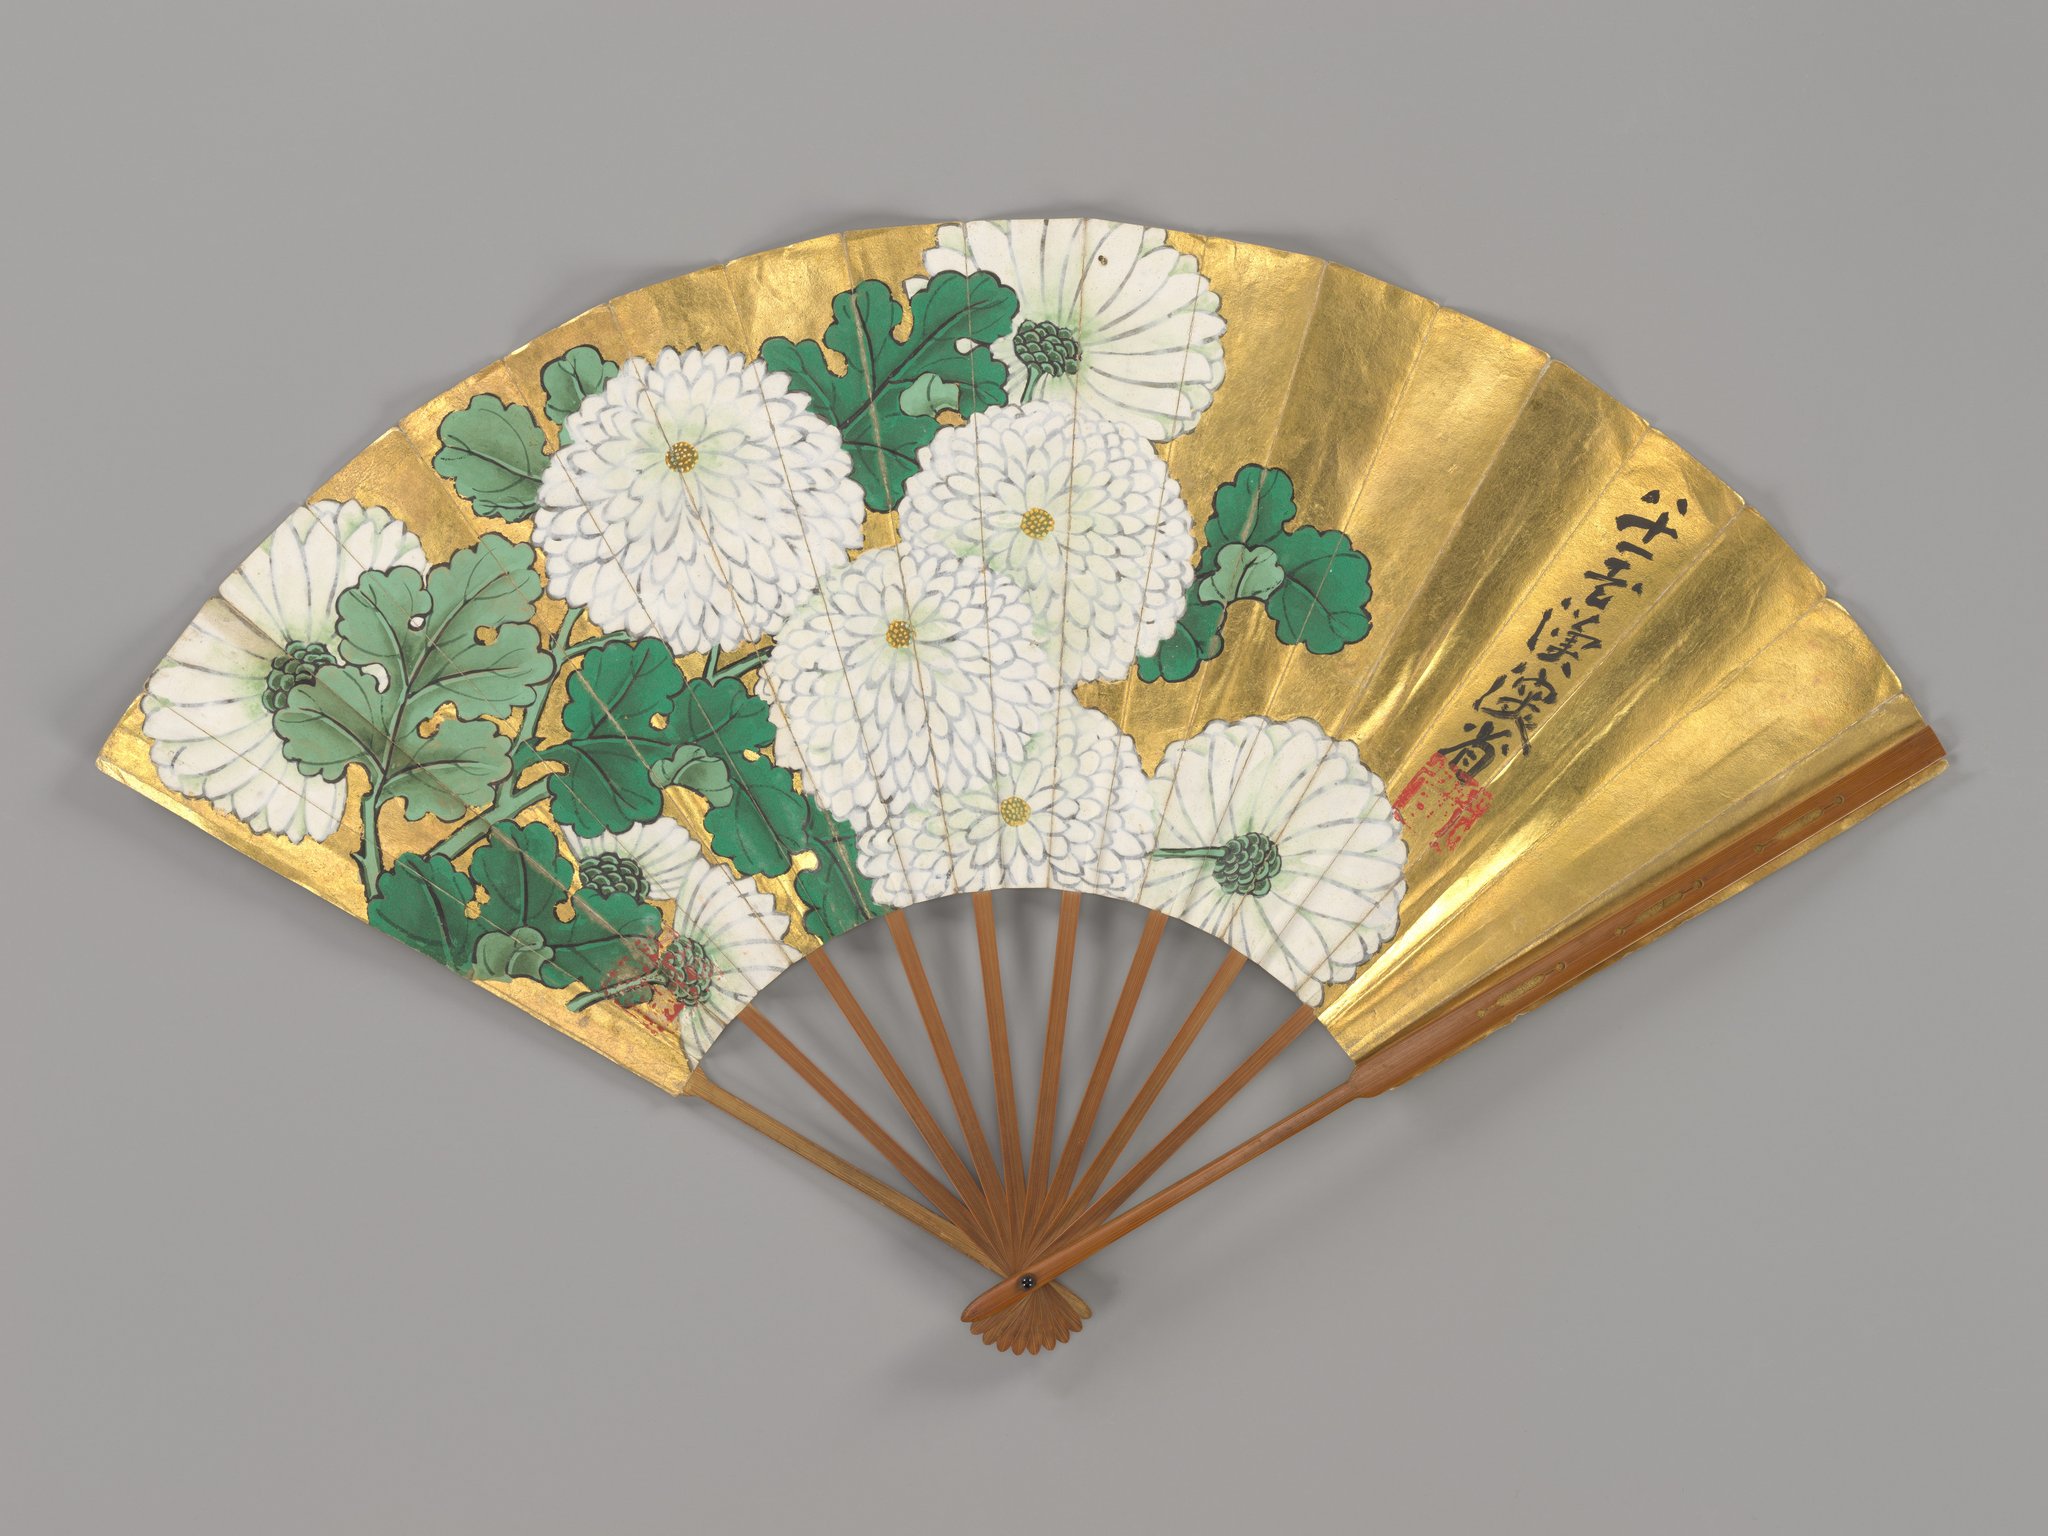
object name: fan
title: Chrysanthemum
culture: japanese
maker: ogata kenzan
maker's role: artist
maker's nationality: japanese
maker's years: 1663-1743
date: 1743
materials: gold, ink, paper